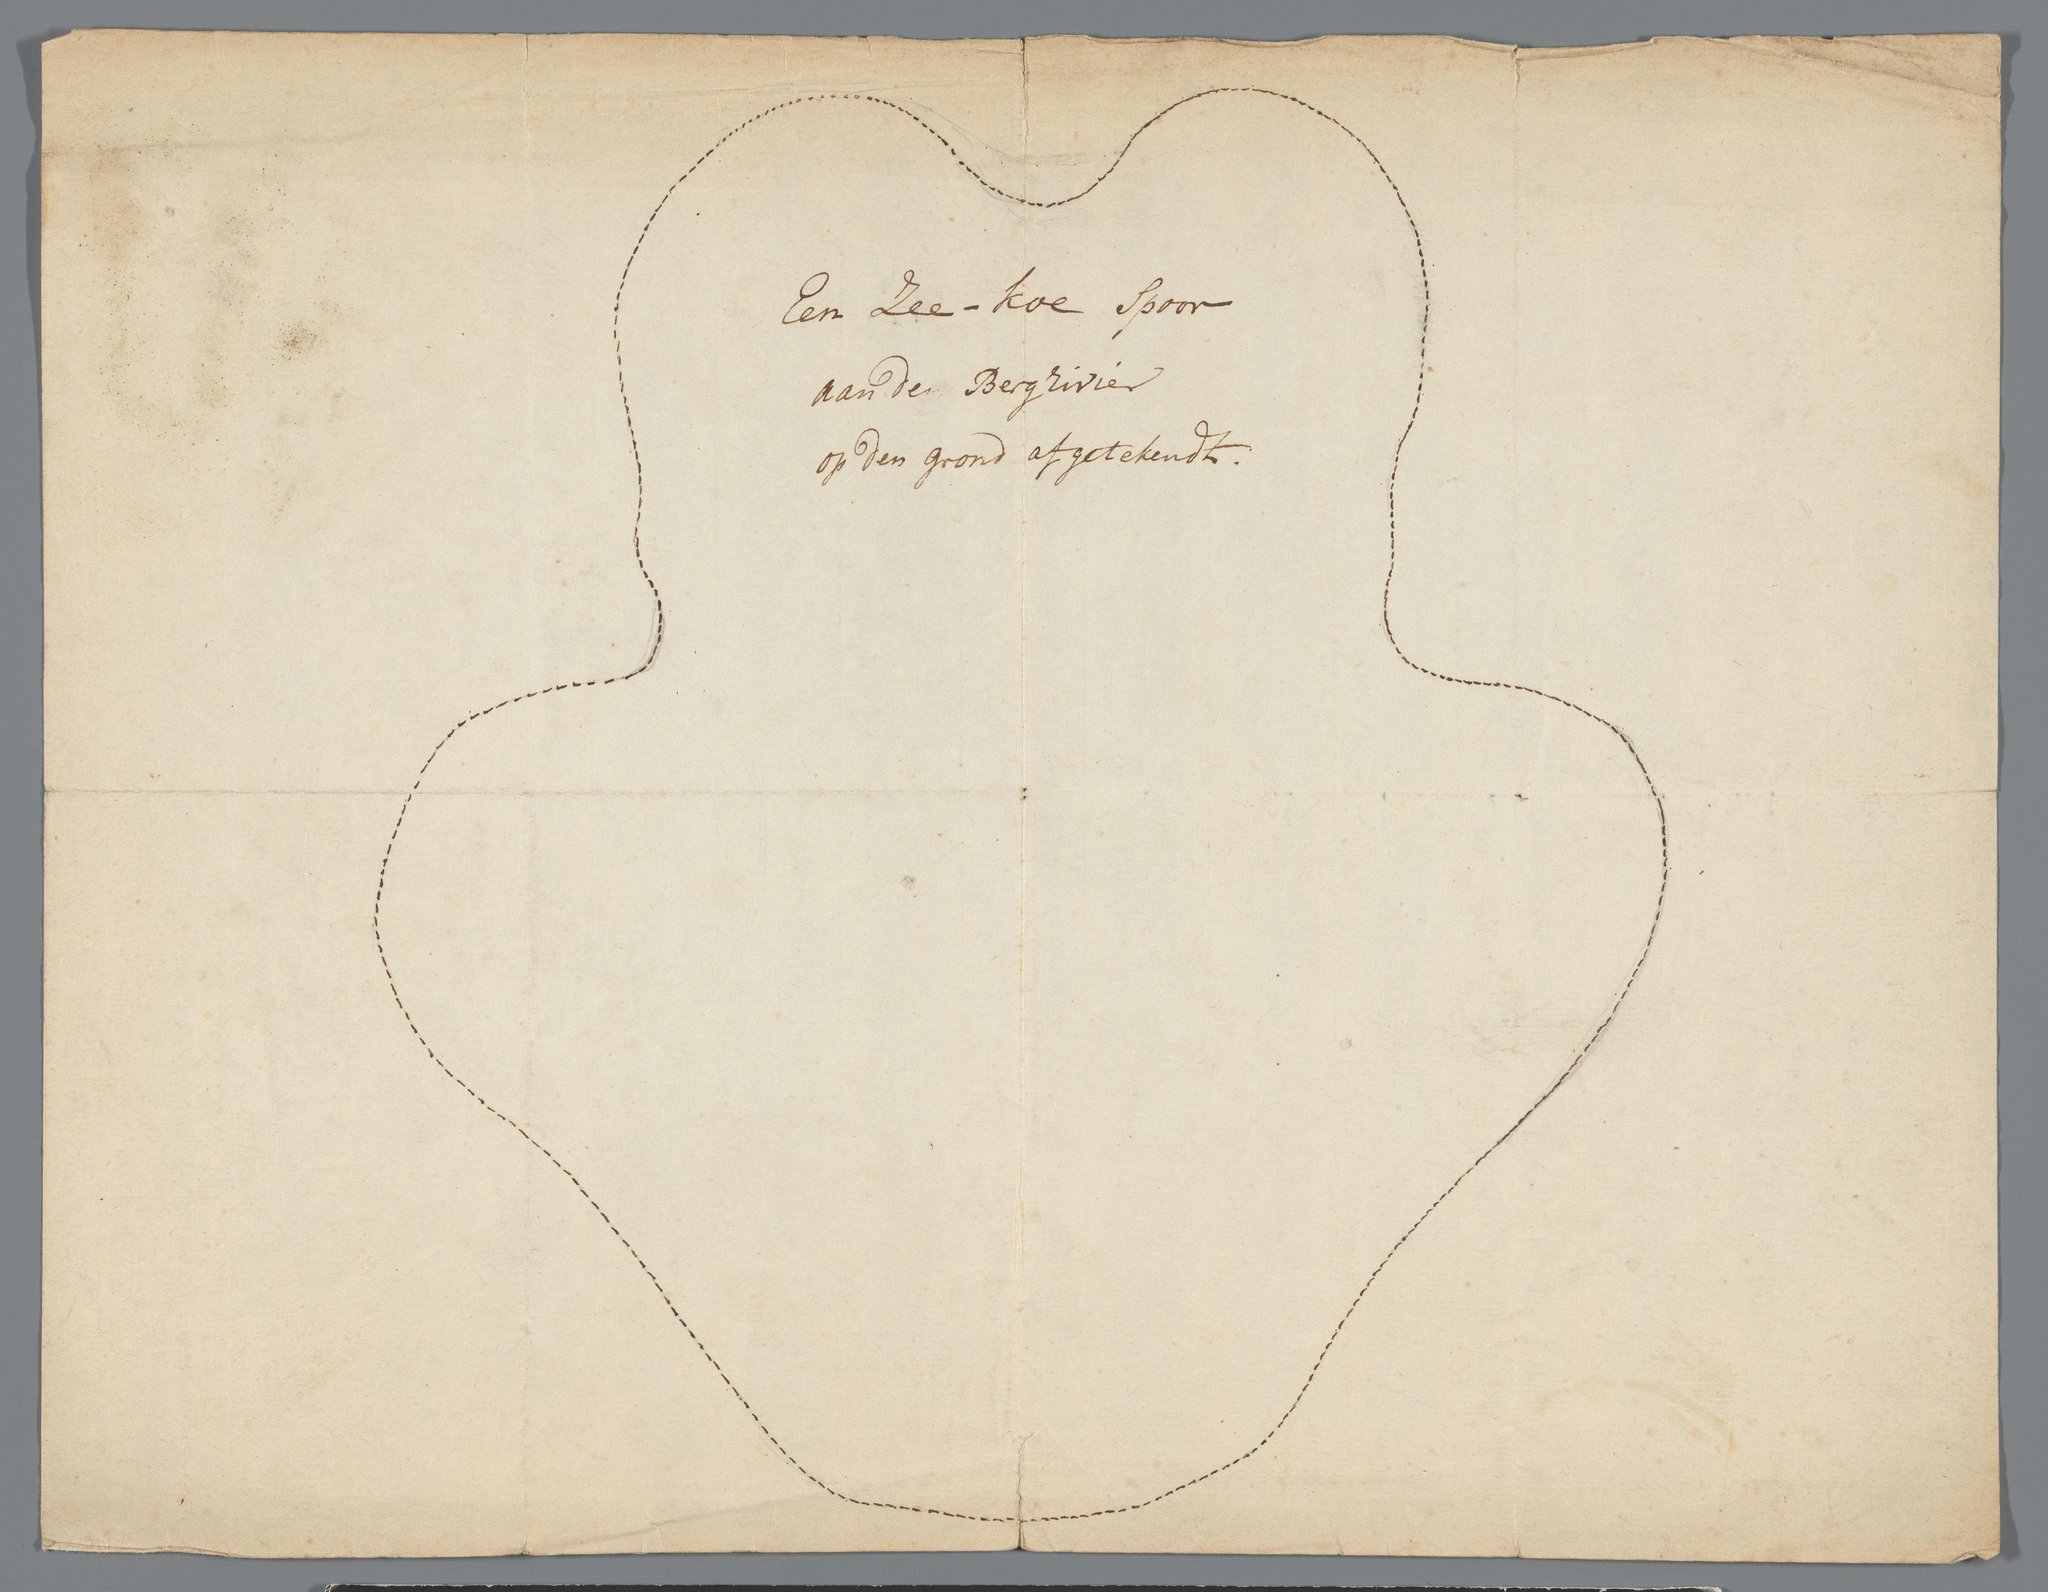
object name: drawing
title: Een Zee-koe spoor aan de Bergrivier op den grond afgetekendt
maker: Anonymous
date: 1707-1776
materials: ink, paper, pencil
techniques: pen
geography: south africa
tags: hoofed animals: hippopotamus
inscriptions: label: ‘A7’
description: Omtrek van een pootafdruk van een 'zeekoe', getekend bij de Bergrivier. Hoogstwaarschijnlijk gaat het om de pootafdruk van een nijlpaard. De tekening is mogelijk gemaakt tijdens de eerste reis van Hendrik Swellengrebel, 18-31 juli 1776. Volgens het reisjournaal ziet het gezelschap verse sporen van nijlpaarden langs de Bergrivier op 24 juli 1776.